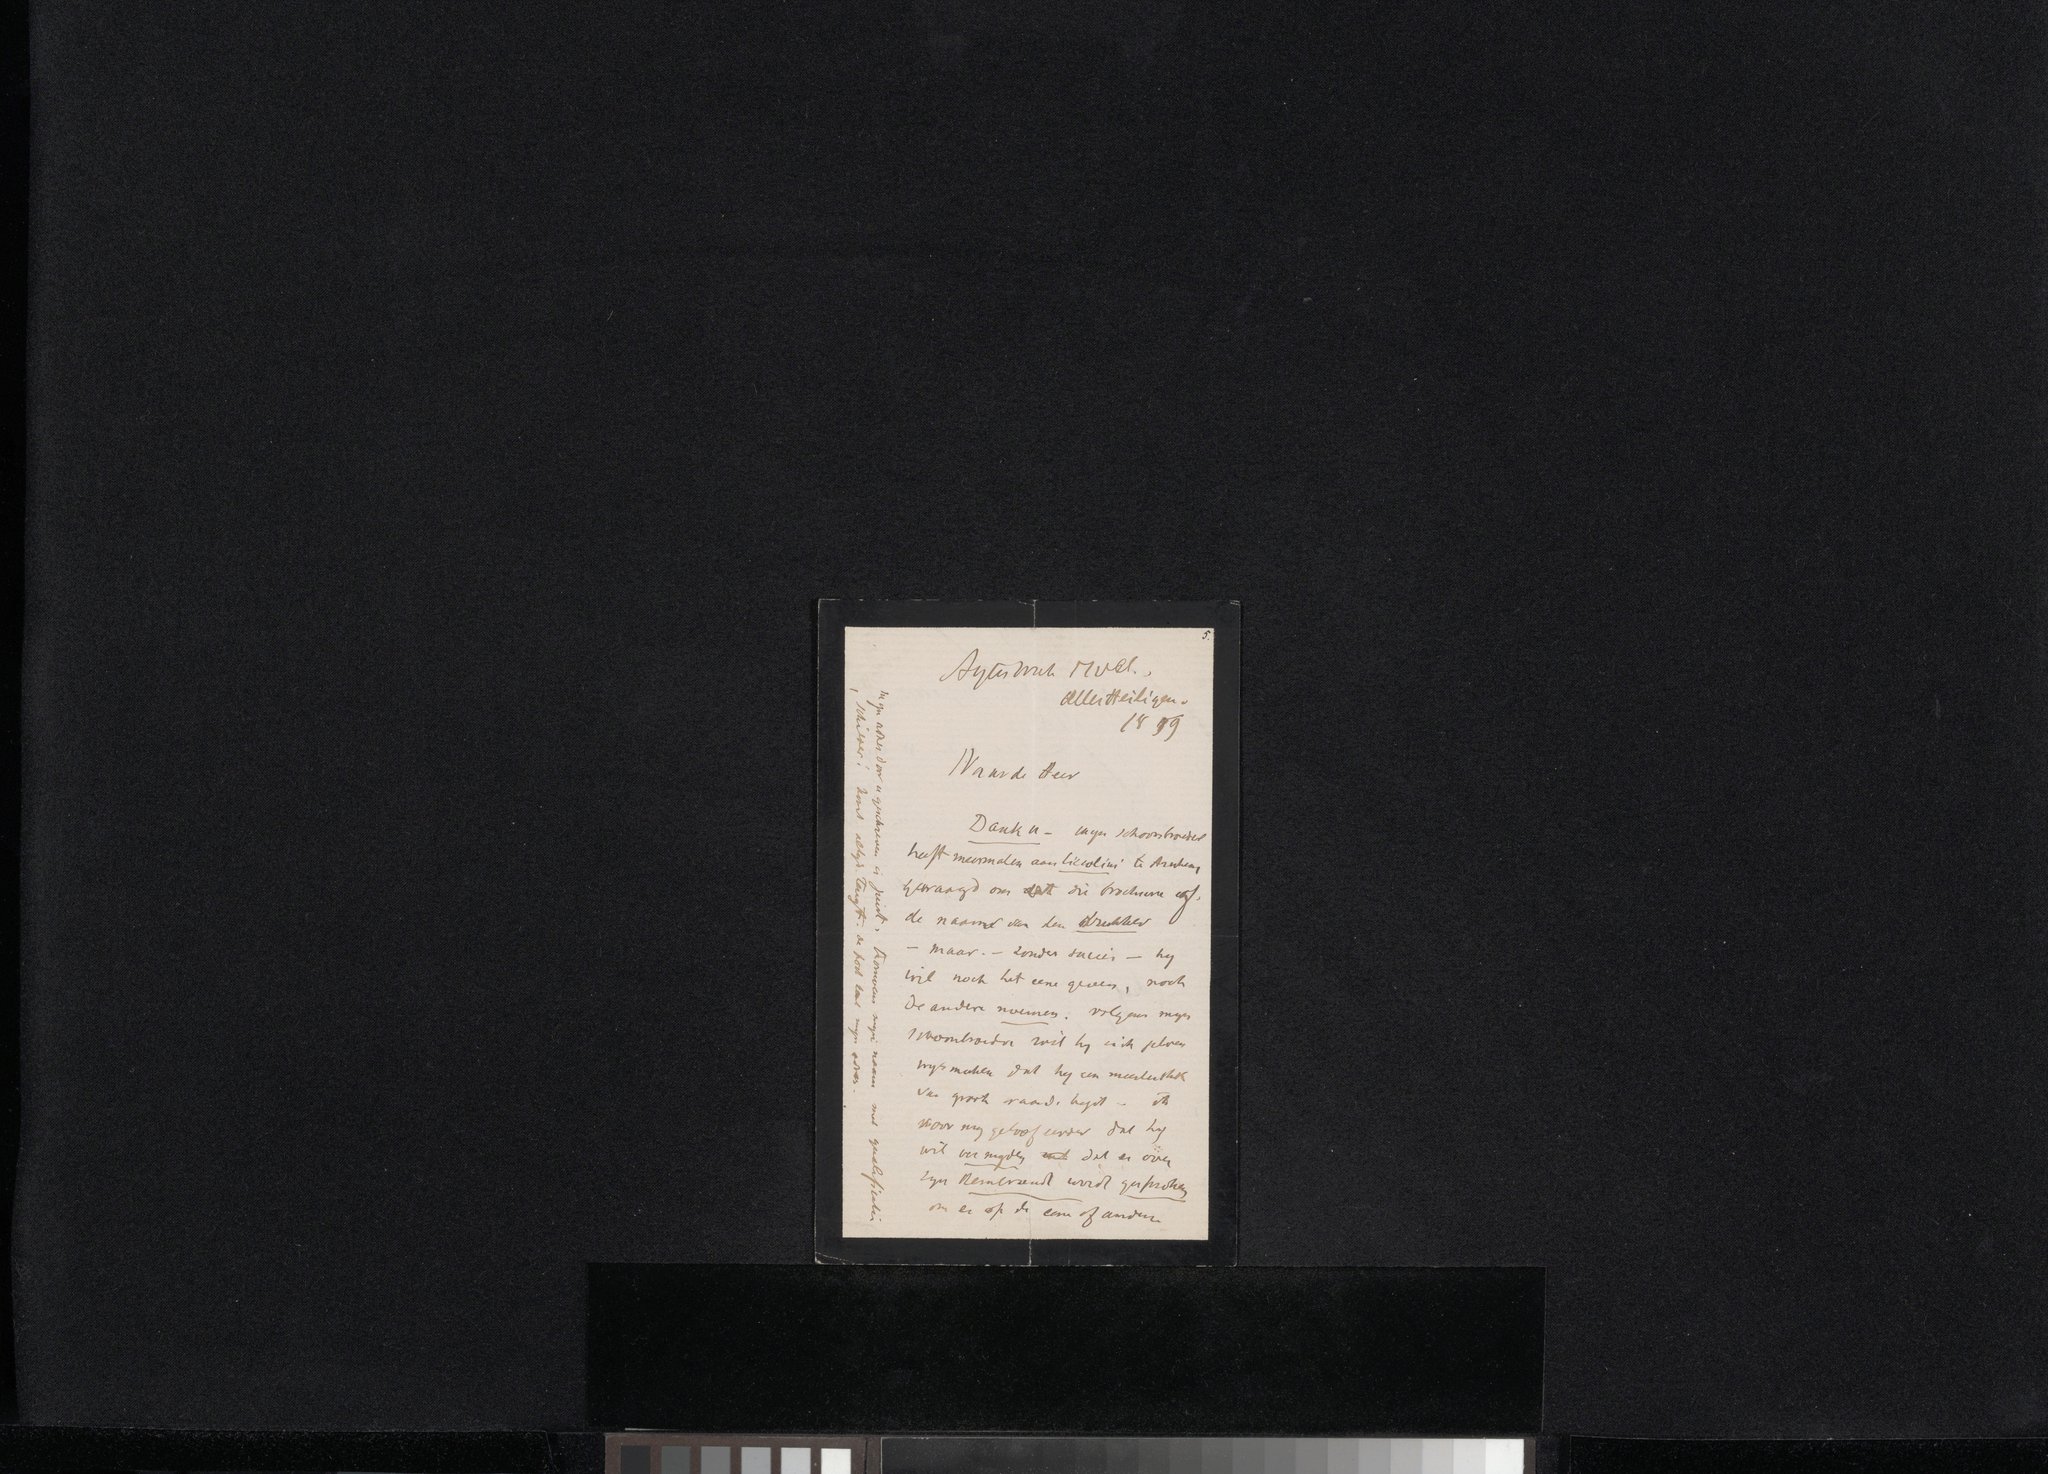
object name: letter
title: Brief aan anoniem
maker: jakob smits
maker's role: draughtsman, print maker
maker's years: 1855-1928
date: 1899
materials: ink, paper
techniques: pen, printing, writing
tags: drawing, exhibition ~ art, historical persons (portraits and scenes from the life), rotterdam, brussels, arnhem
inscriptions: collector's mark: ‘RPK’